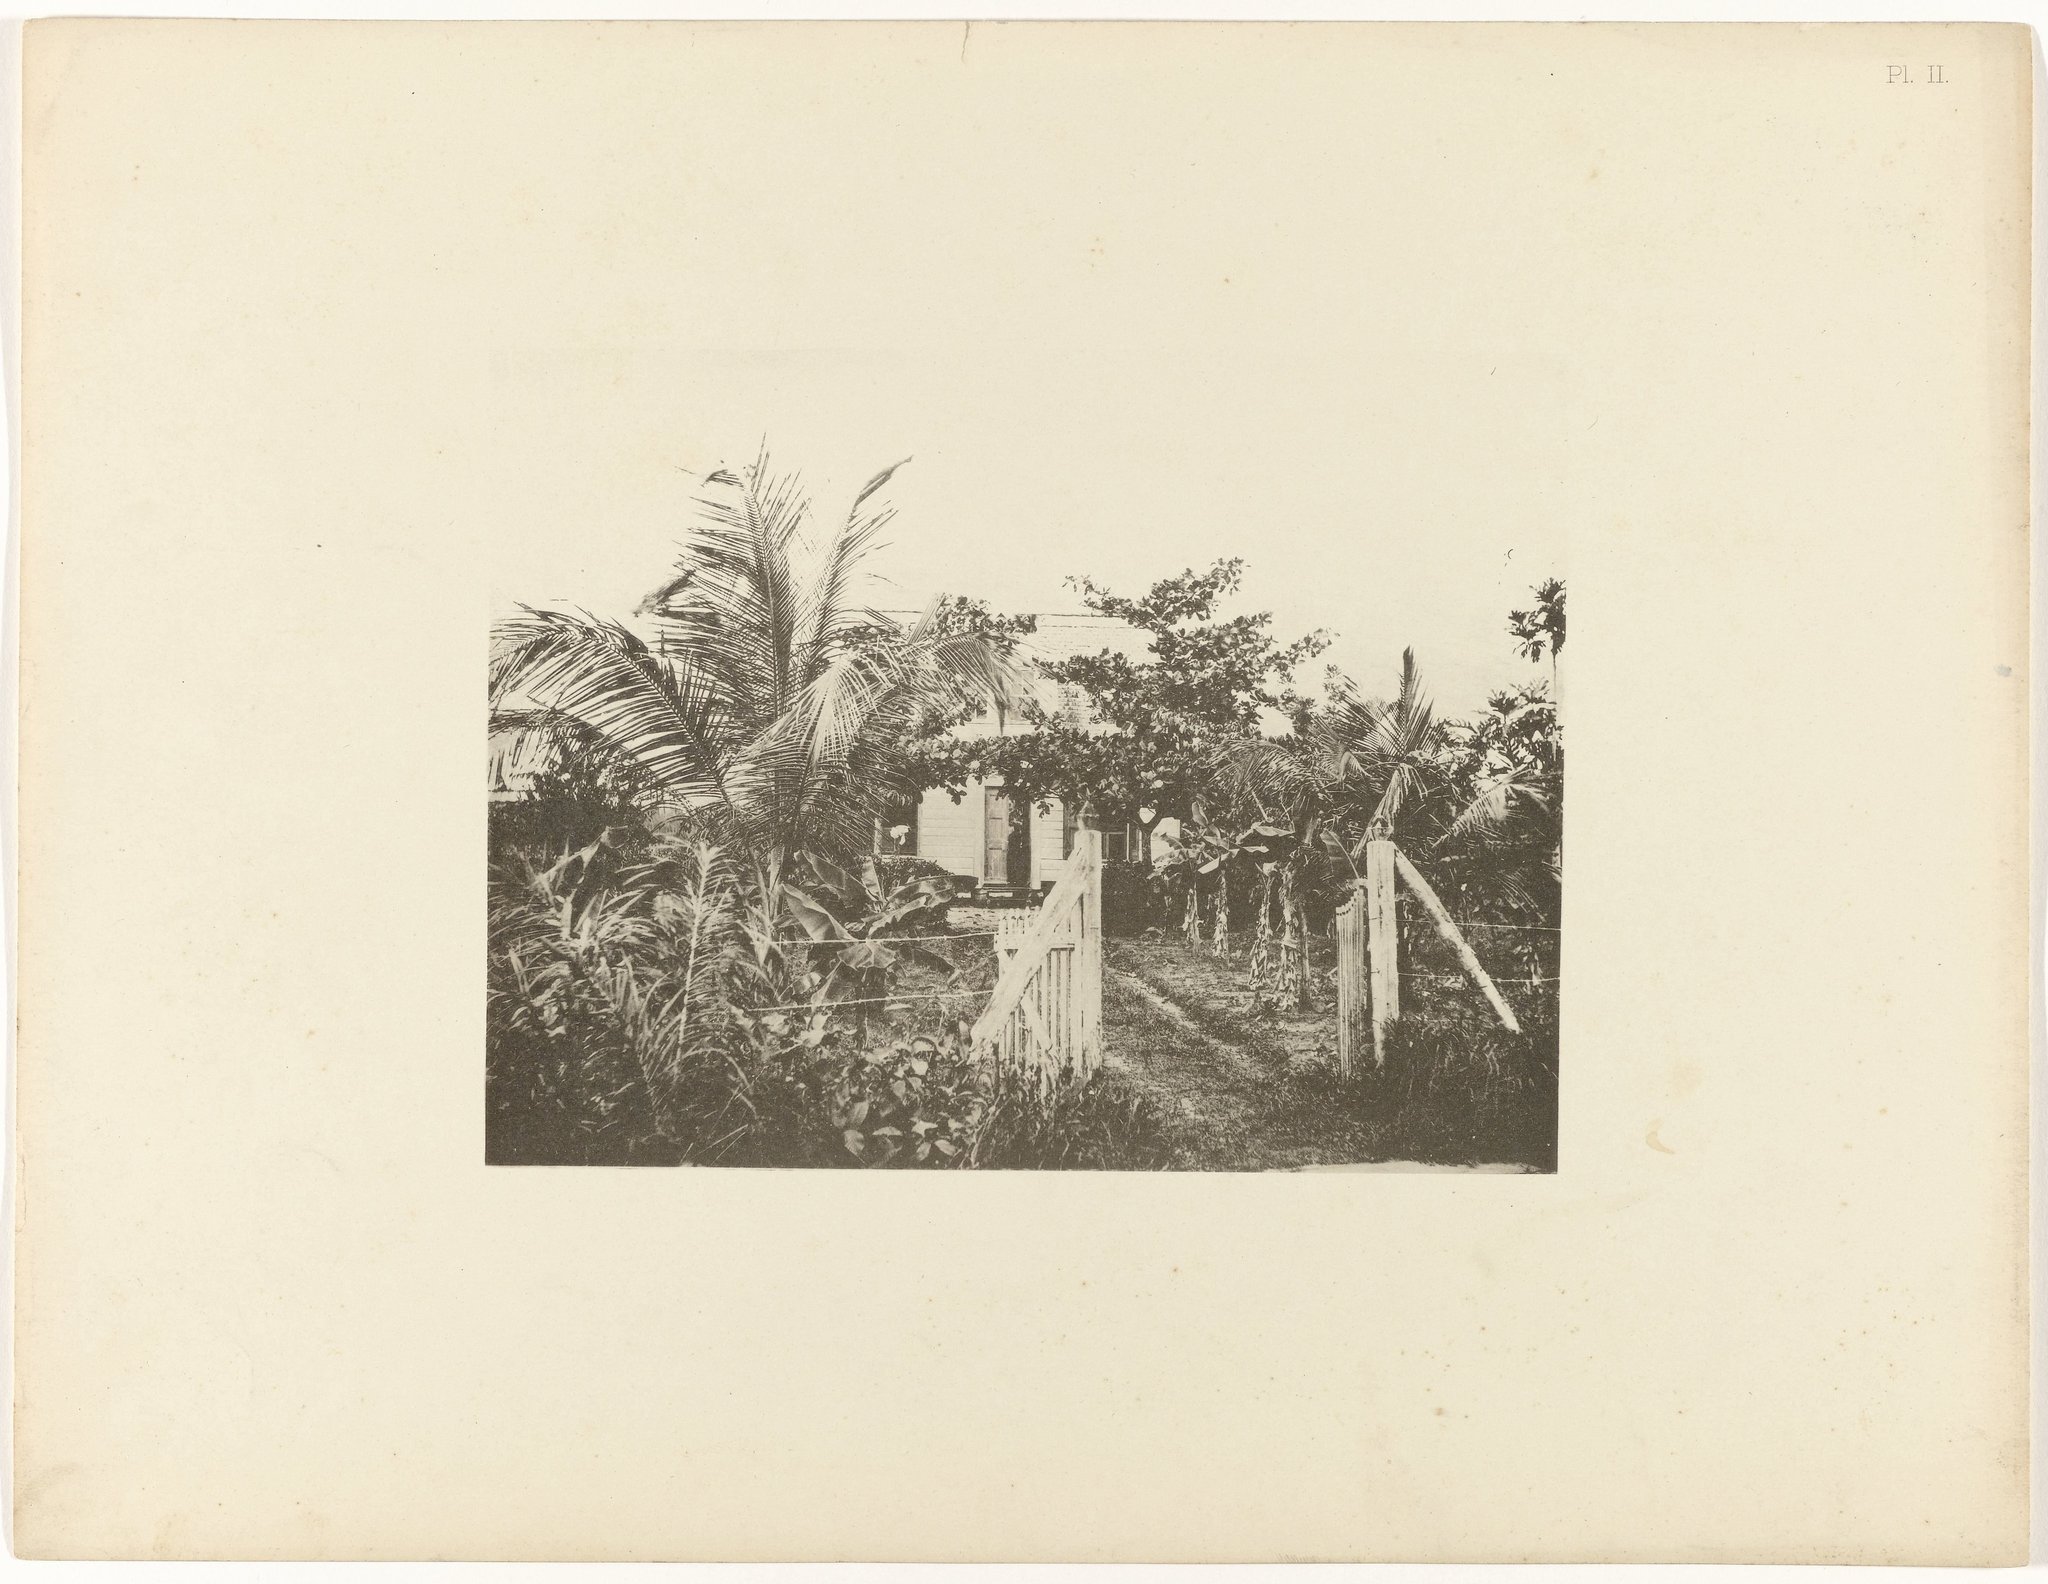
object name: photomechanical print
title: Plantage Kroonenburg, Suriname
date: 1896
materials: paper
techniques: photograph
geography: haarlem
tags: plantation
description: Volgens de bijhorende titel uit de inhoudsopgave zou dit de boerderij van Rosenburg zijn, maar de titels van de eerste en tweede plaat lijken omgekeerd te zijn.